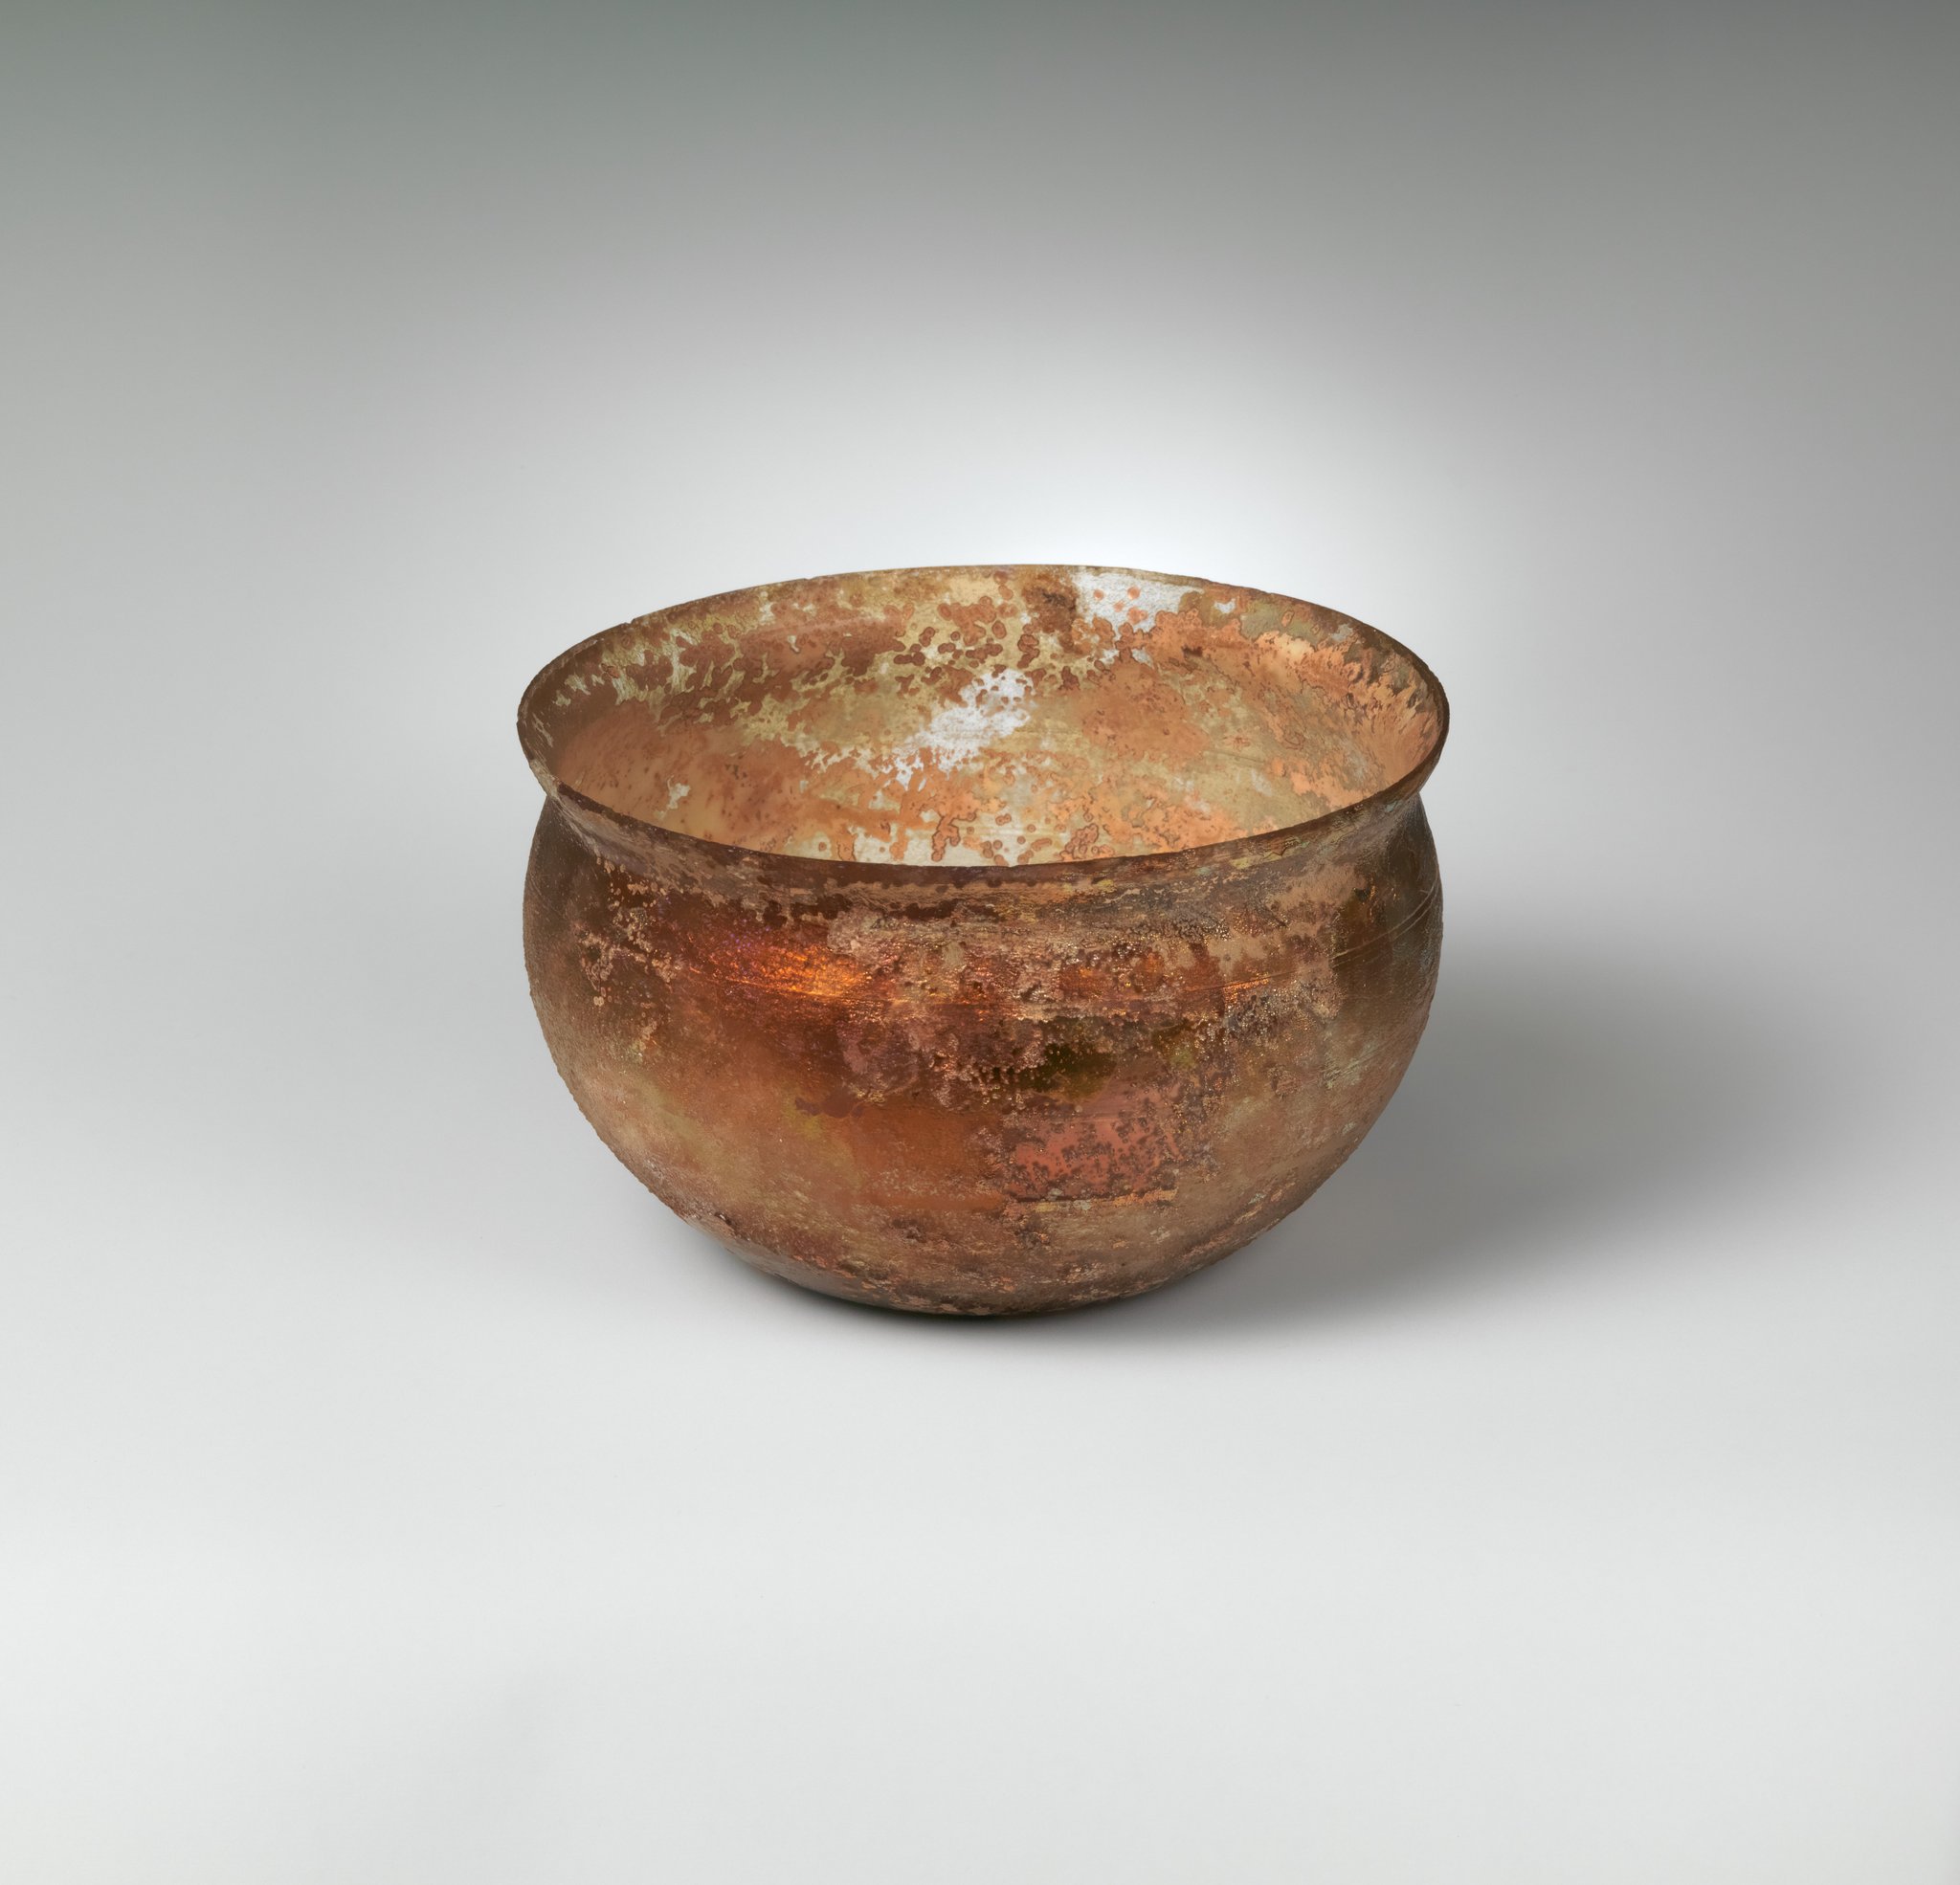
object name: bowl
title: Glass bowl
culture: roman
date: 1-100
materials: glass